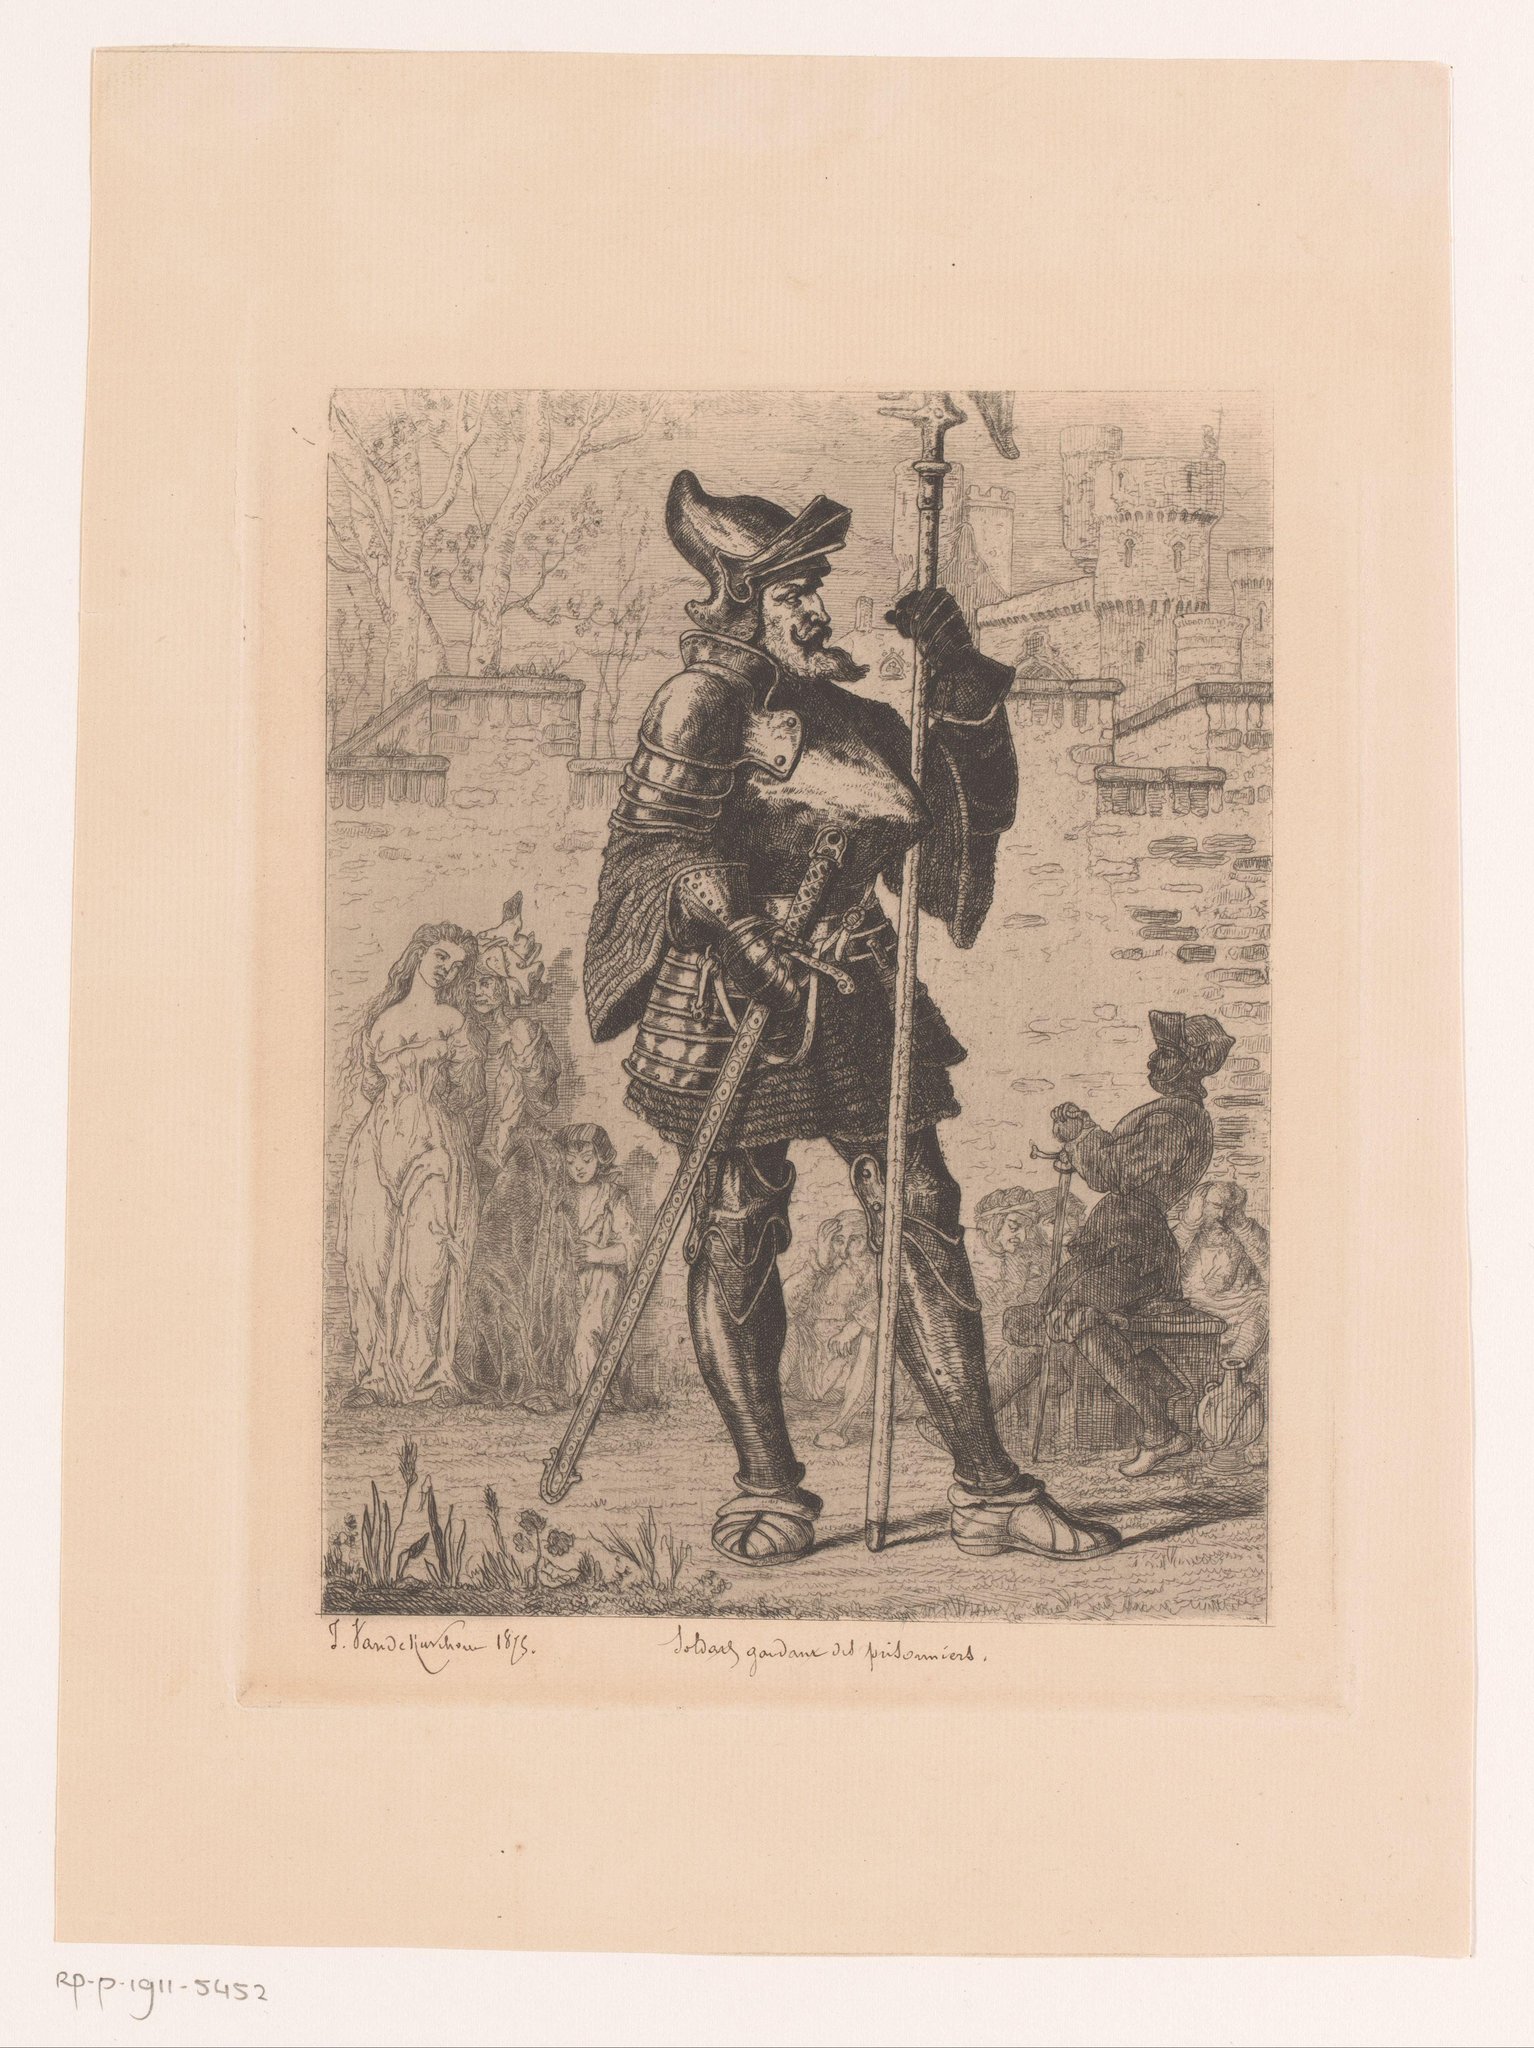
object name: print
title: Soldats gardant les prisonniers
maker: jan van de kerkhove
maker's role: print maker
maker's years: 1822-1881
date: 1875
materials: paper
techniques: drypoint, etching, intaglio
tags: prison personnel: jailers, warders, guards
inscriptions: collector's mark: Lugt 2228